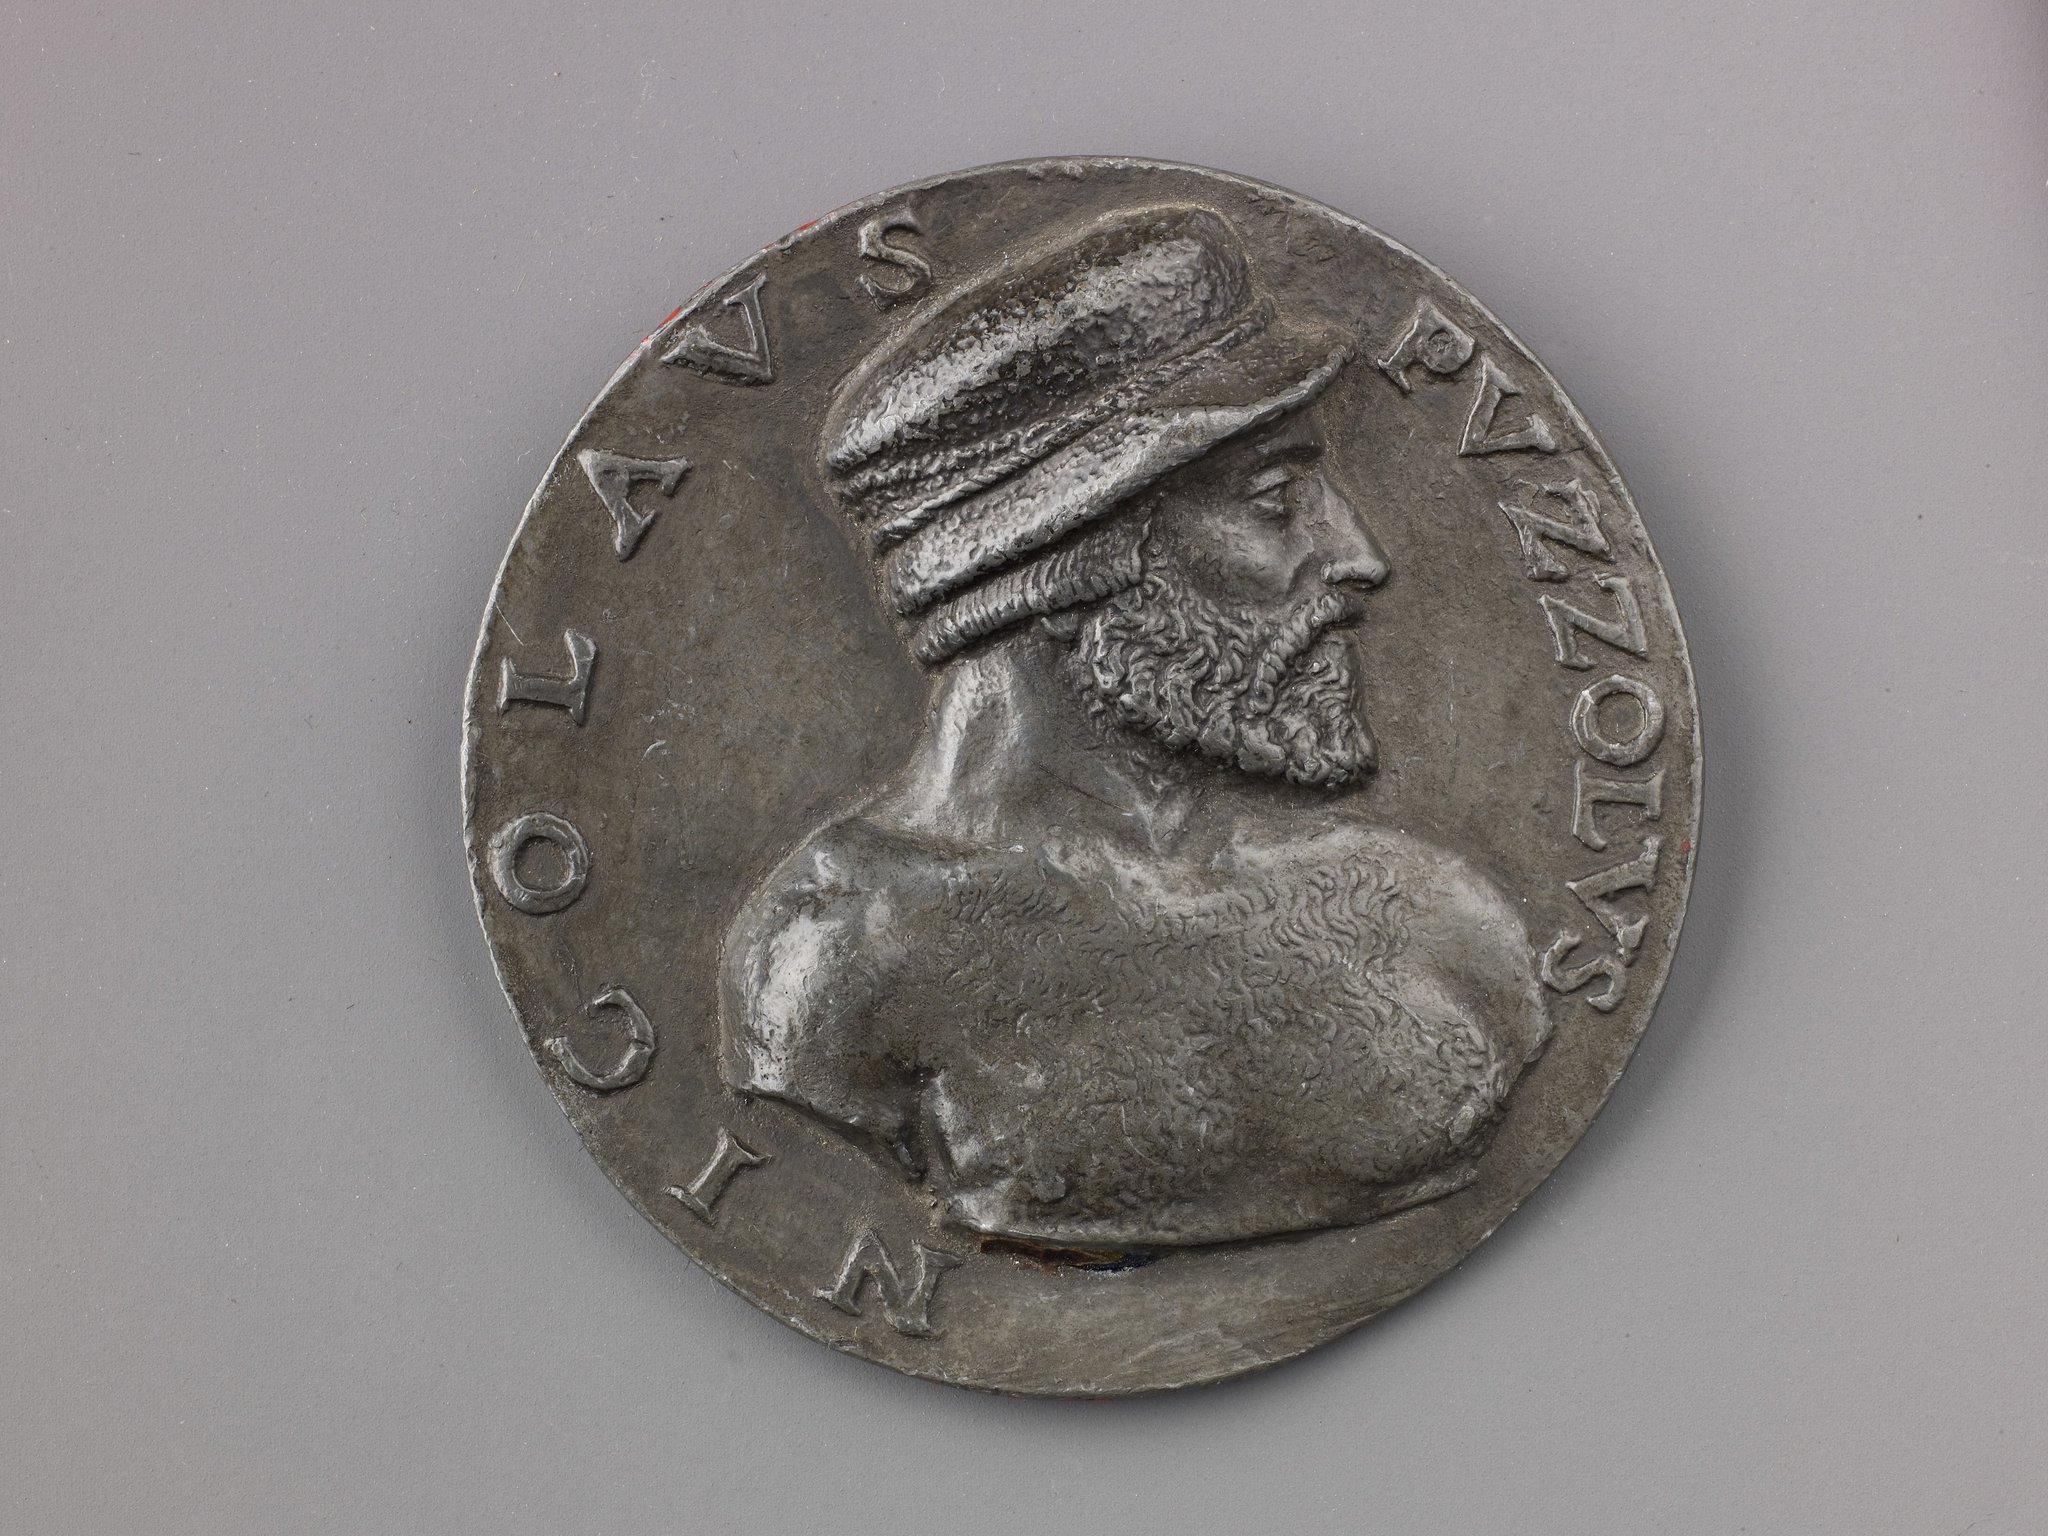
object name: medal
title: Medal: Niccolo Puzzolo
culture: italian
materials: lead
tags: buildings,men,profiles